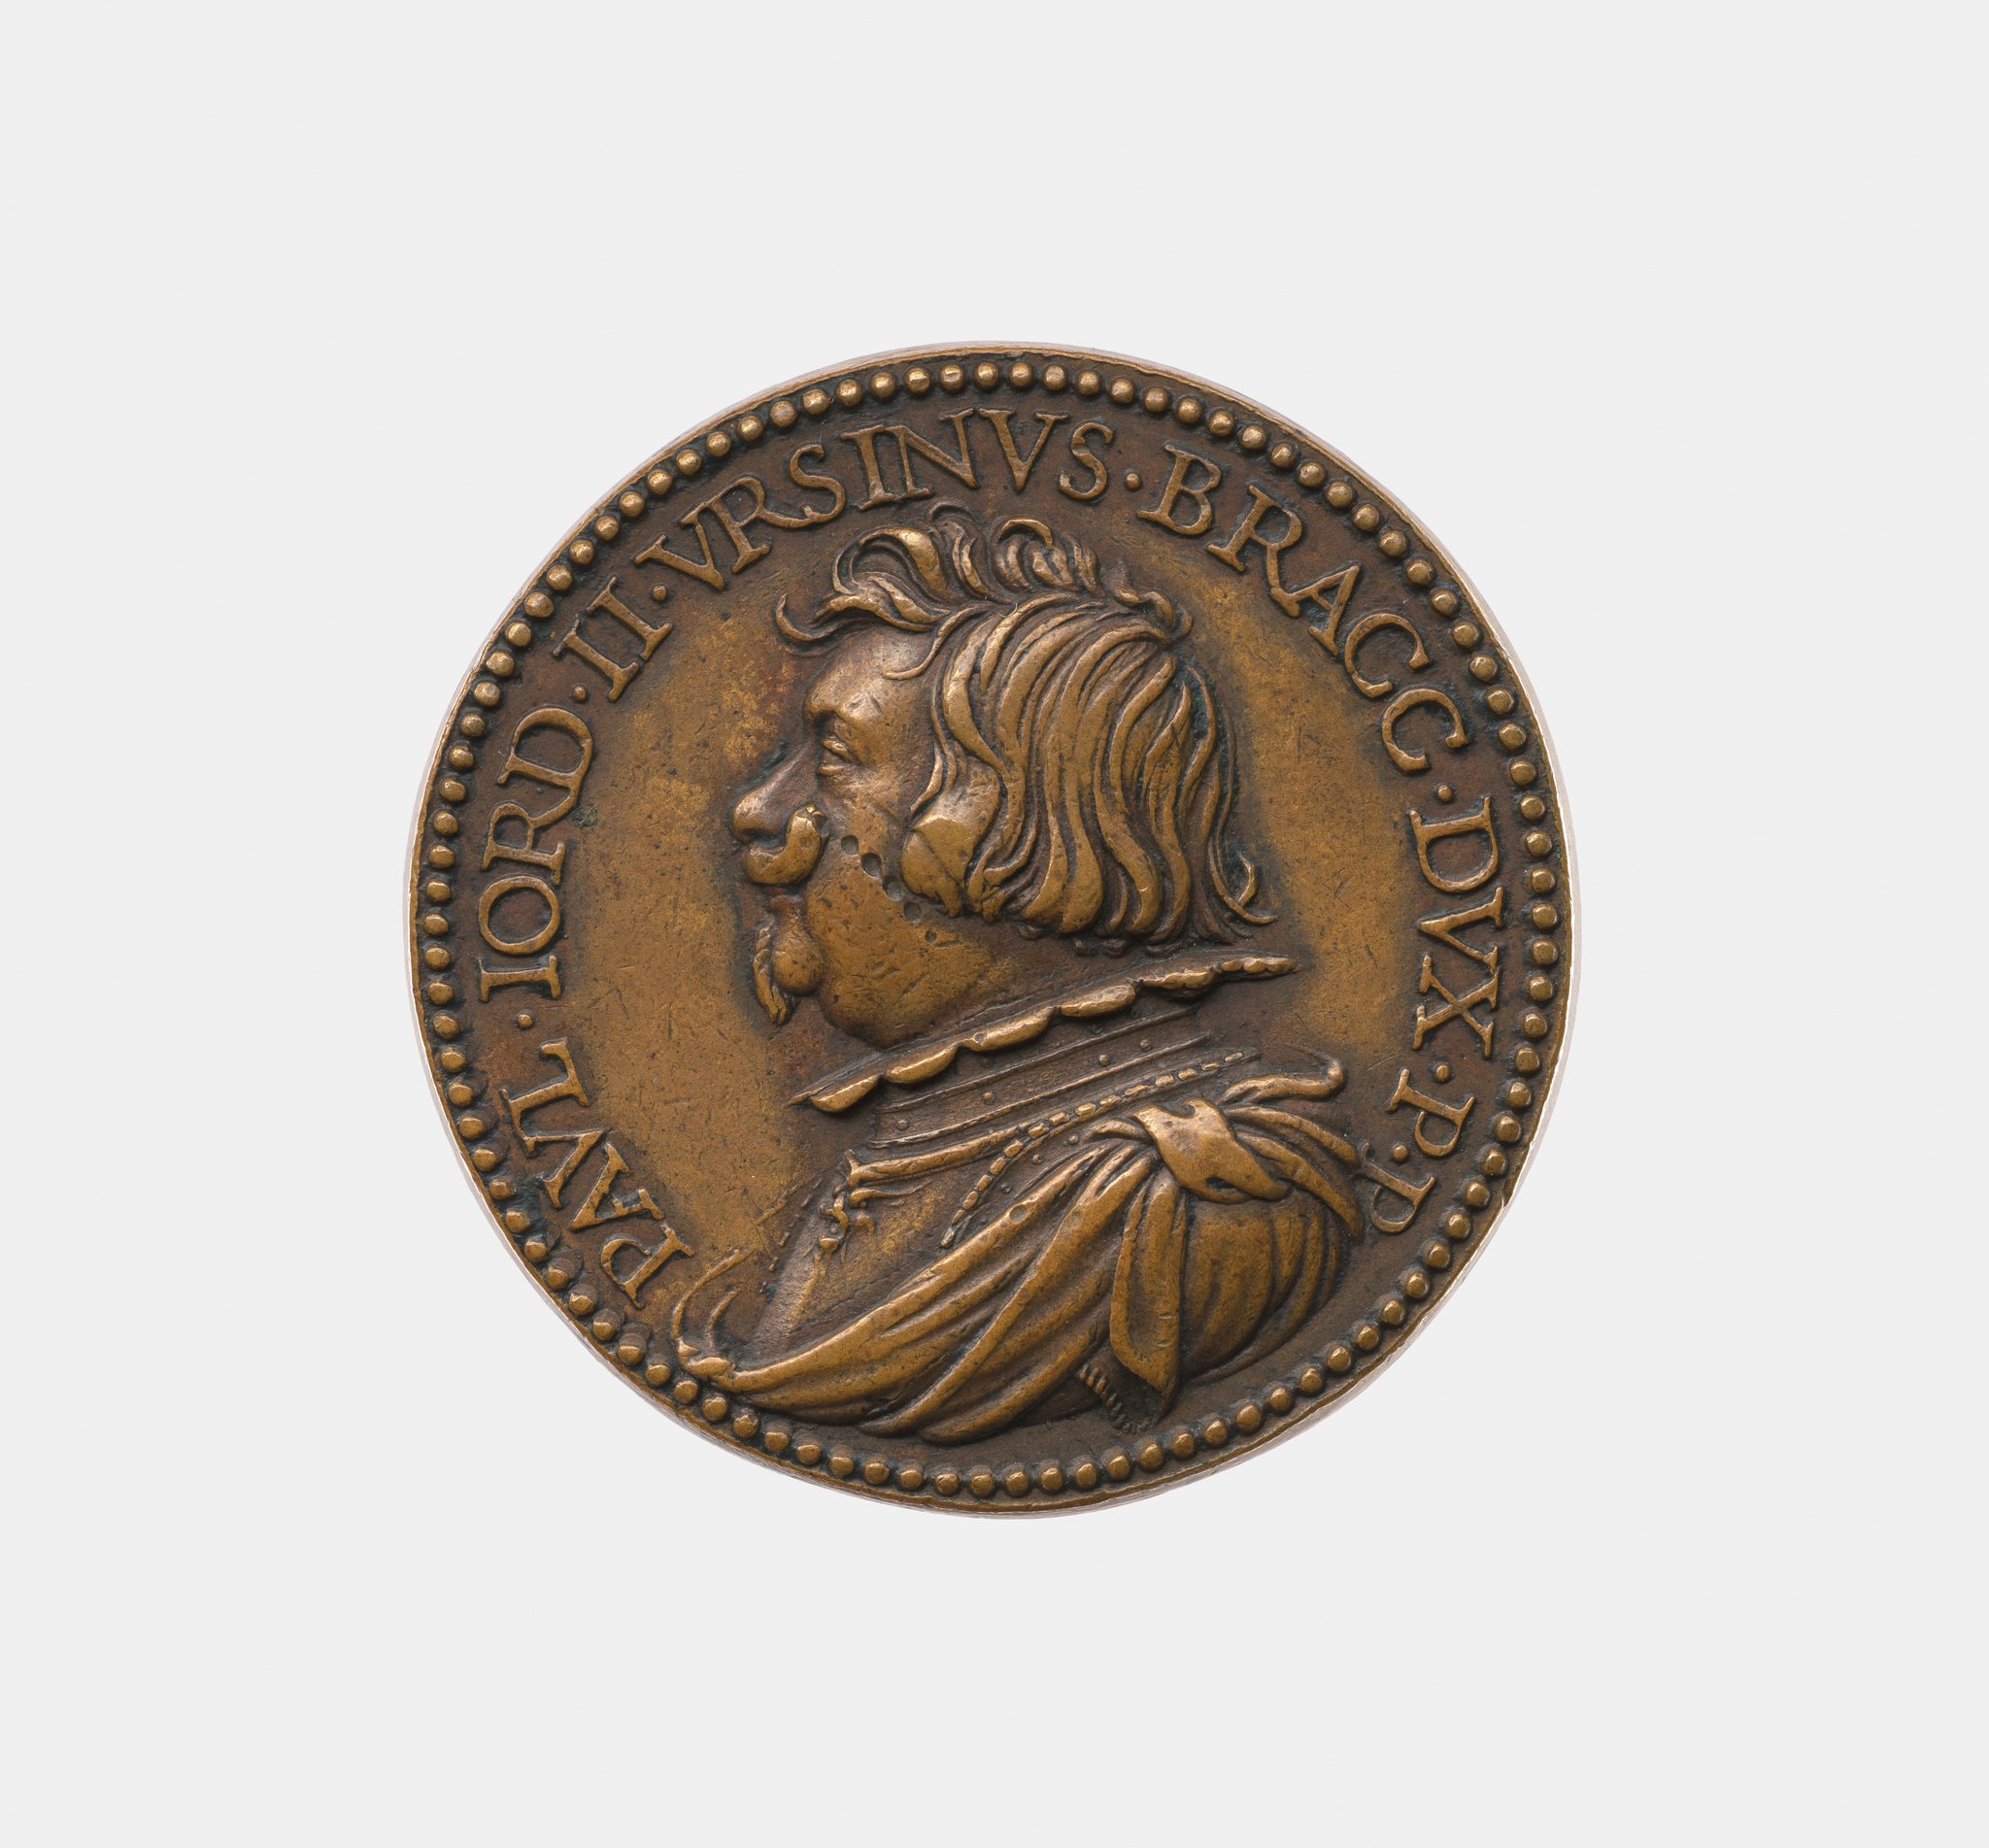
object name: medal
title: Paolo Giordano II Orsini (1591–1656)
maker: johann jakob kornmann (called cormano)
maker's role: artist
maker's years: 1620-1700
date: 1635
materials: bronze